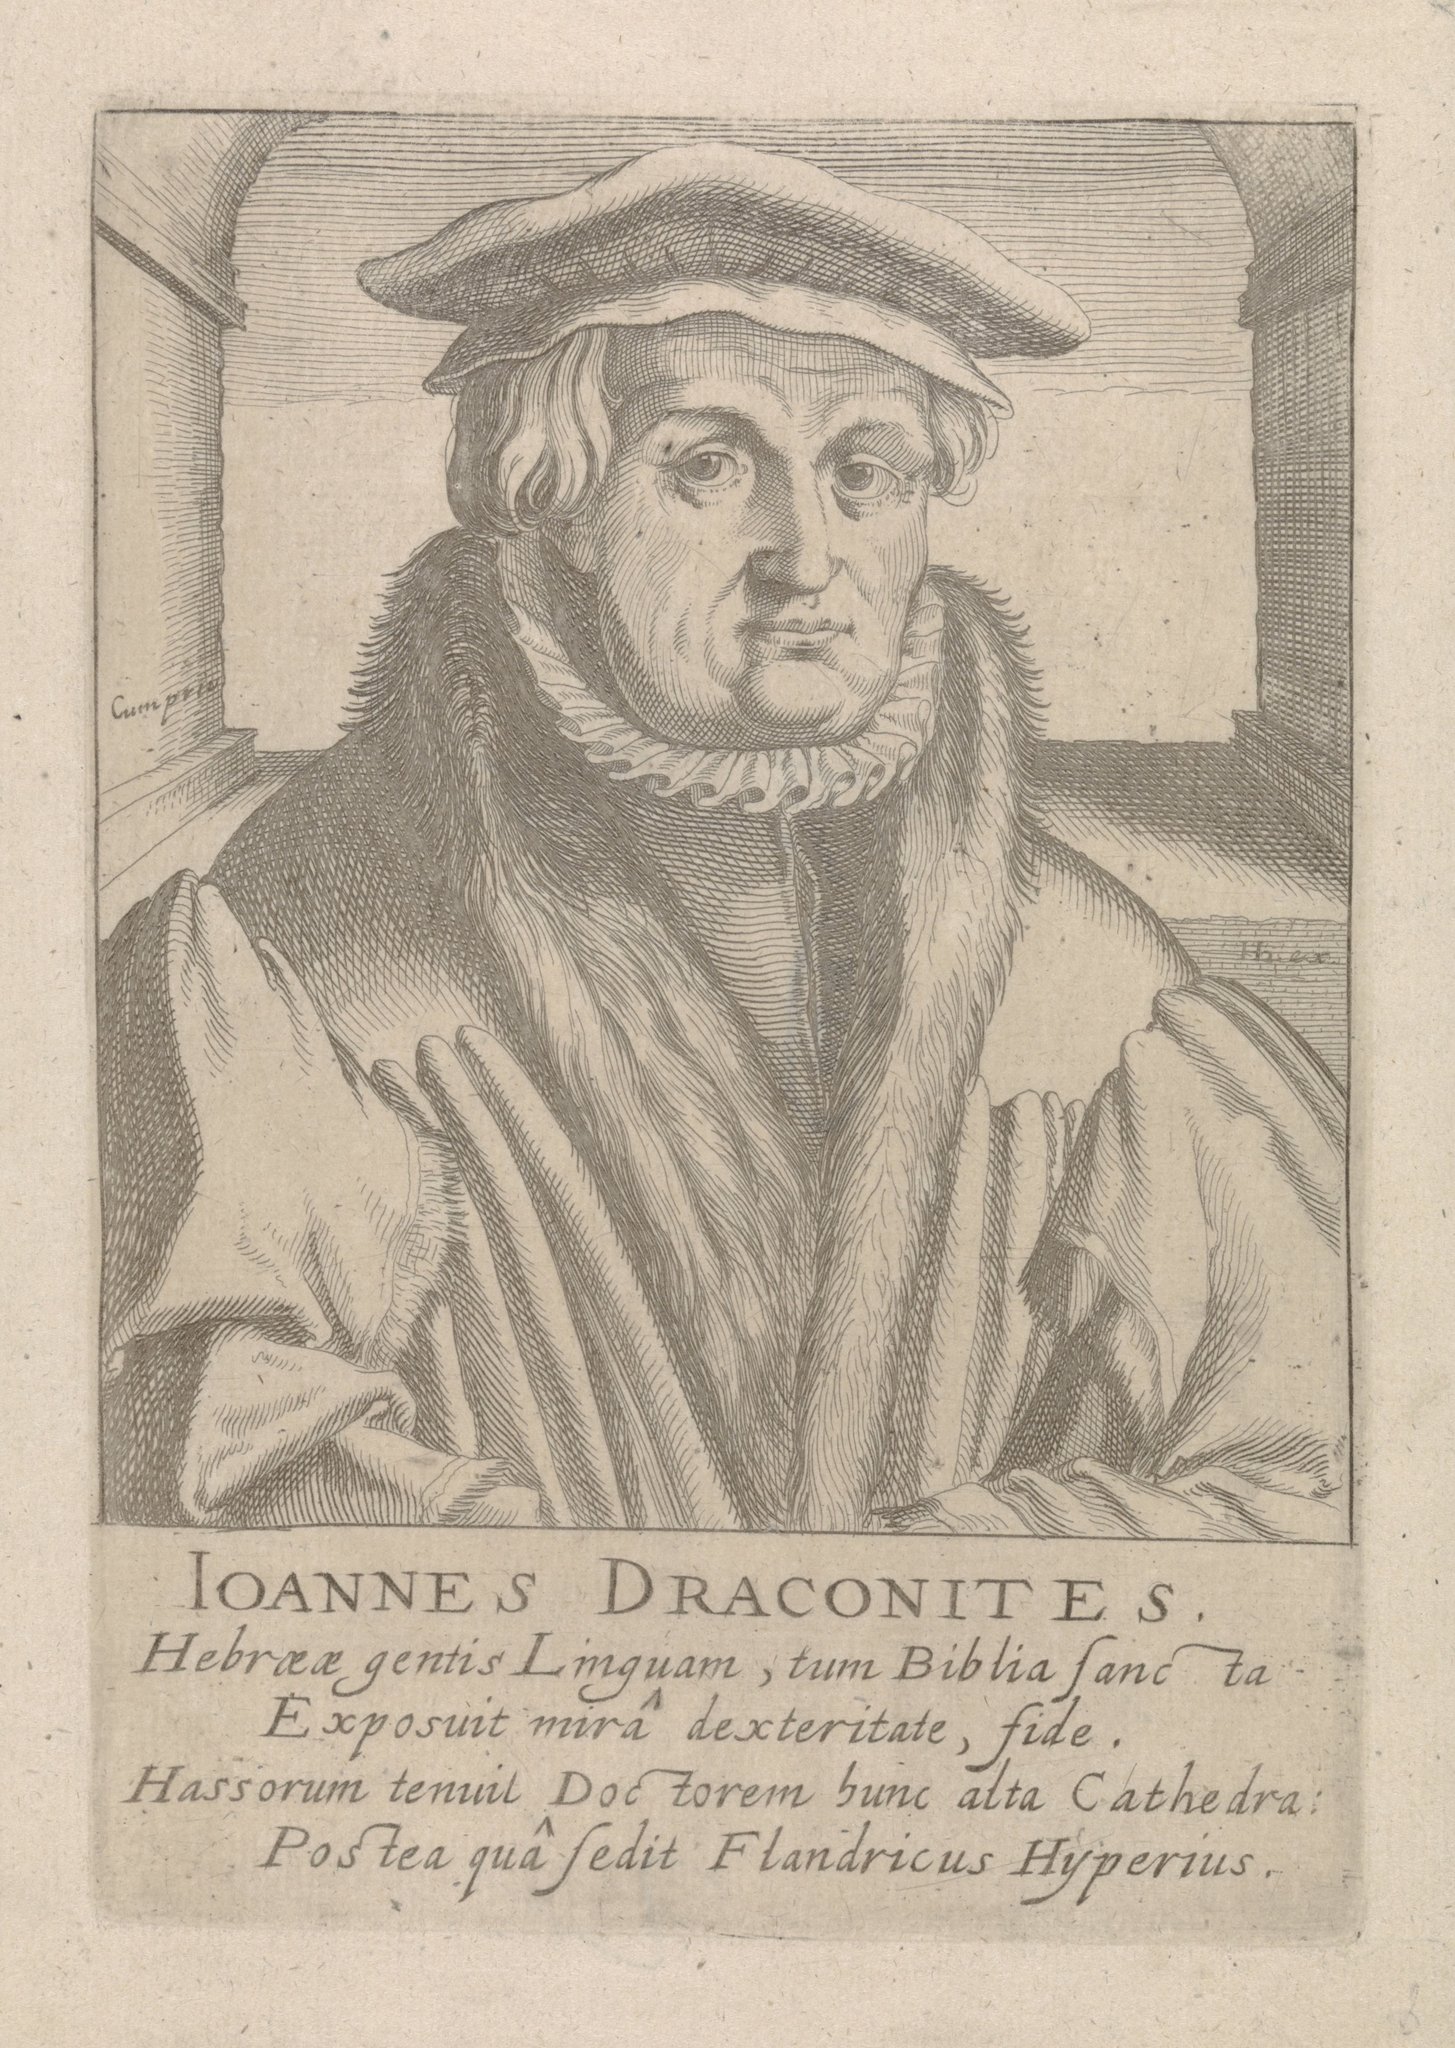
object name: print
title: Portret van Johann Draconites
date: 1610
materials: paper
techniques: etching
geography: the hague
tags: johann draconites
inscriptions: collector's mark: Lugt 2228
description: Buste naar rechts van Johann Draconites. Onder het portret zijn naam en vier regels in het Latijn. Prent uit het later toegevoegde deel 2 (28 prenten) van de serie portretten van beroemde hervormers door Hendrick Hondius uit 1599.